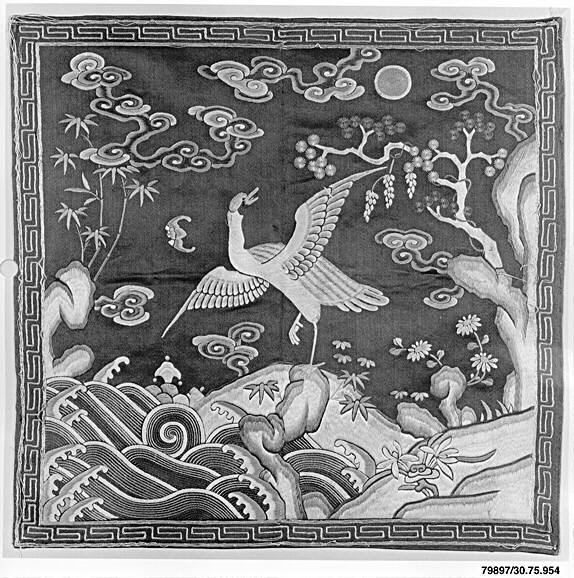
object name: rank badge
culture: chinese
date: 1701-1800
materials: metal thread, silk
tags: bats,birds